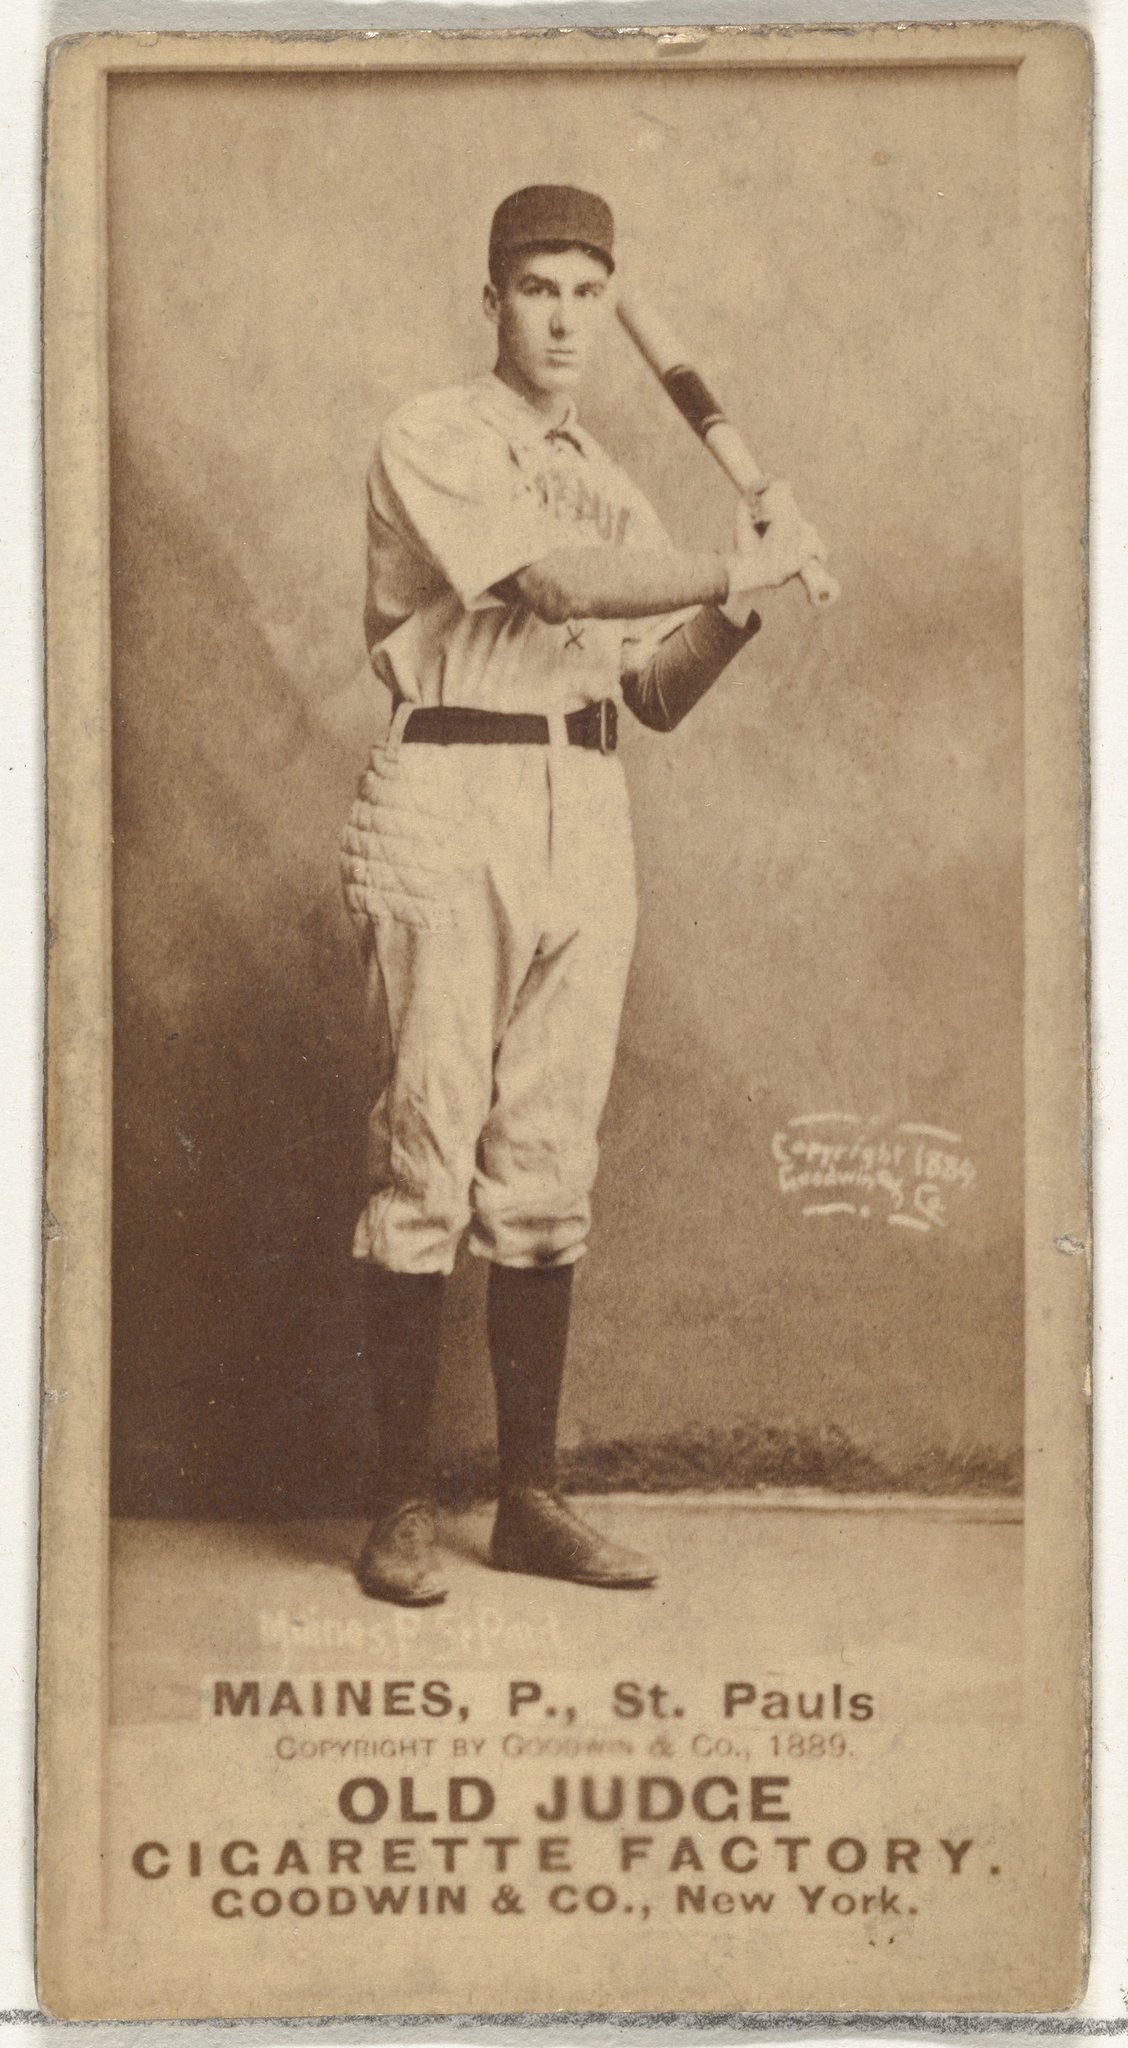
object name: baseball card, photograph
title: Willard Eben Mains, Pitcher, St. Paul Apostles, from the Old Judge series (N172) for Old Judge Cigarettes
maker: goodwin & company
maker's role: publisher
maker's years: 1850-1950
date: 1889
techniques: albumen silver print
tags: men,portraits,baseball,athletes